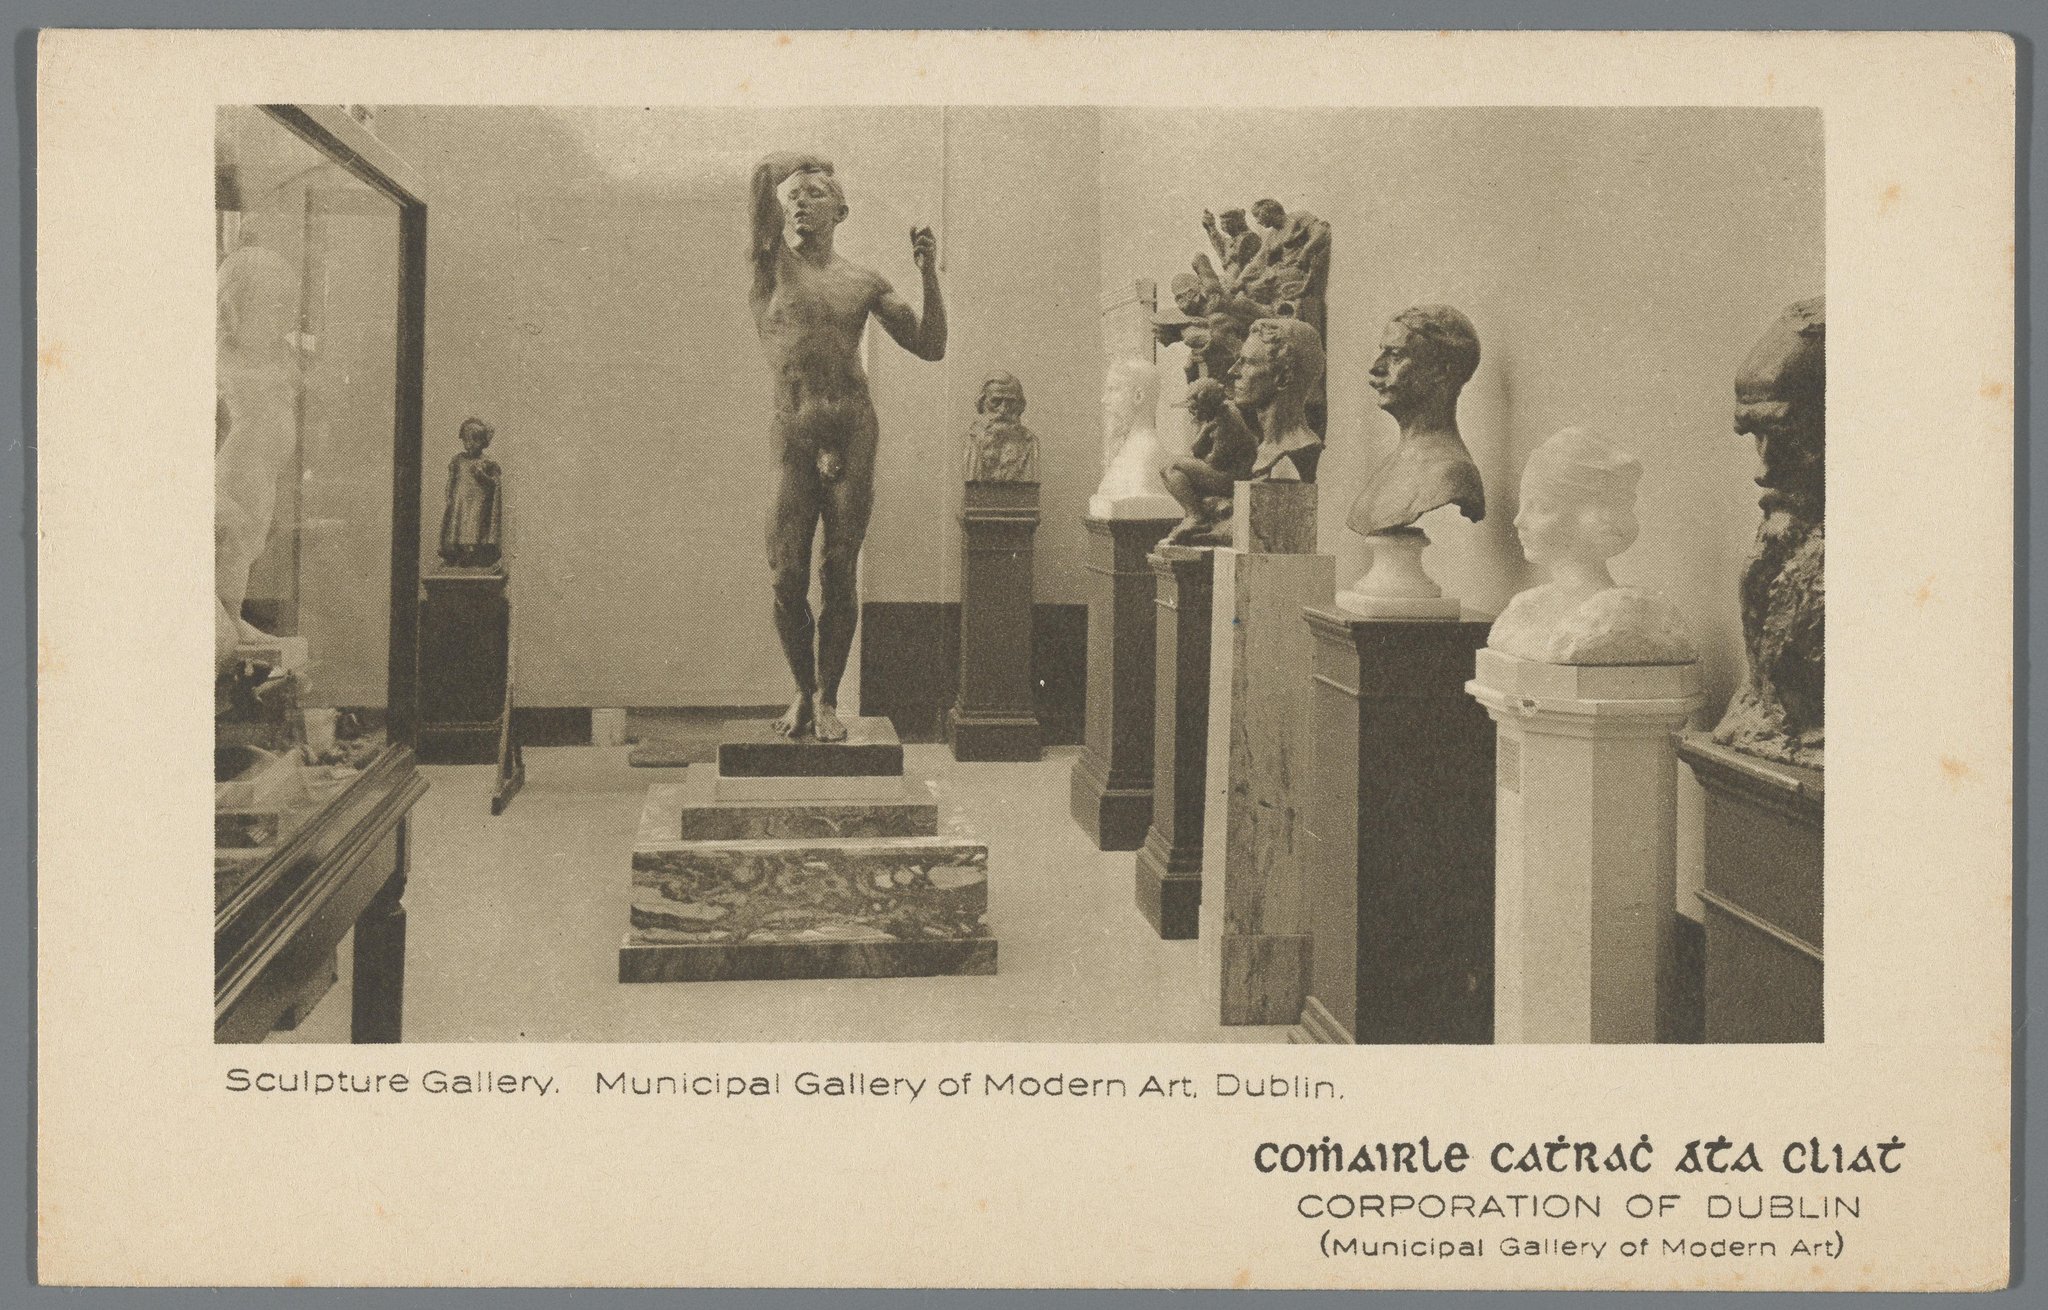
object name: postcard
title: Sculpture Gallery. Municipal Gallery of Modern Art, Dublin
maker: Anonymous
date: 1920-1950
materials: photographic support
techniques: rotogravure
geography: dublin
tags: dublin